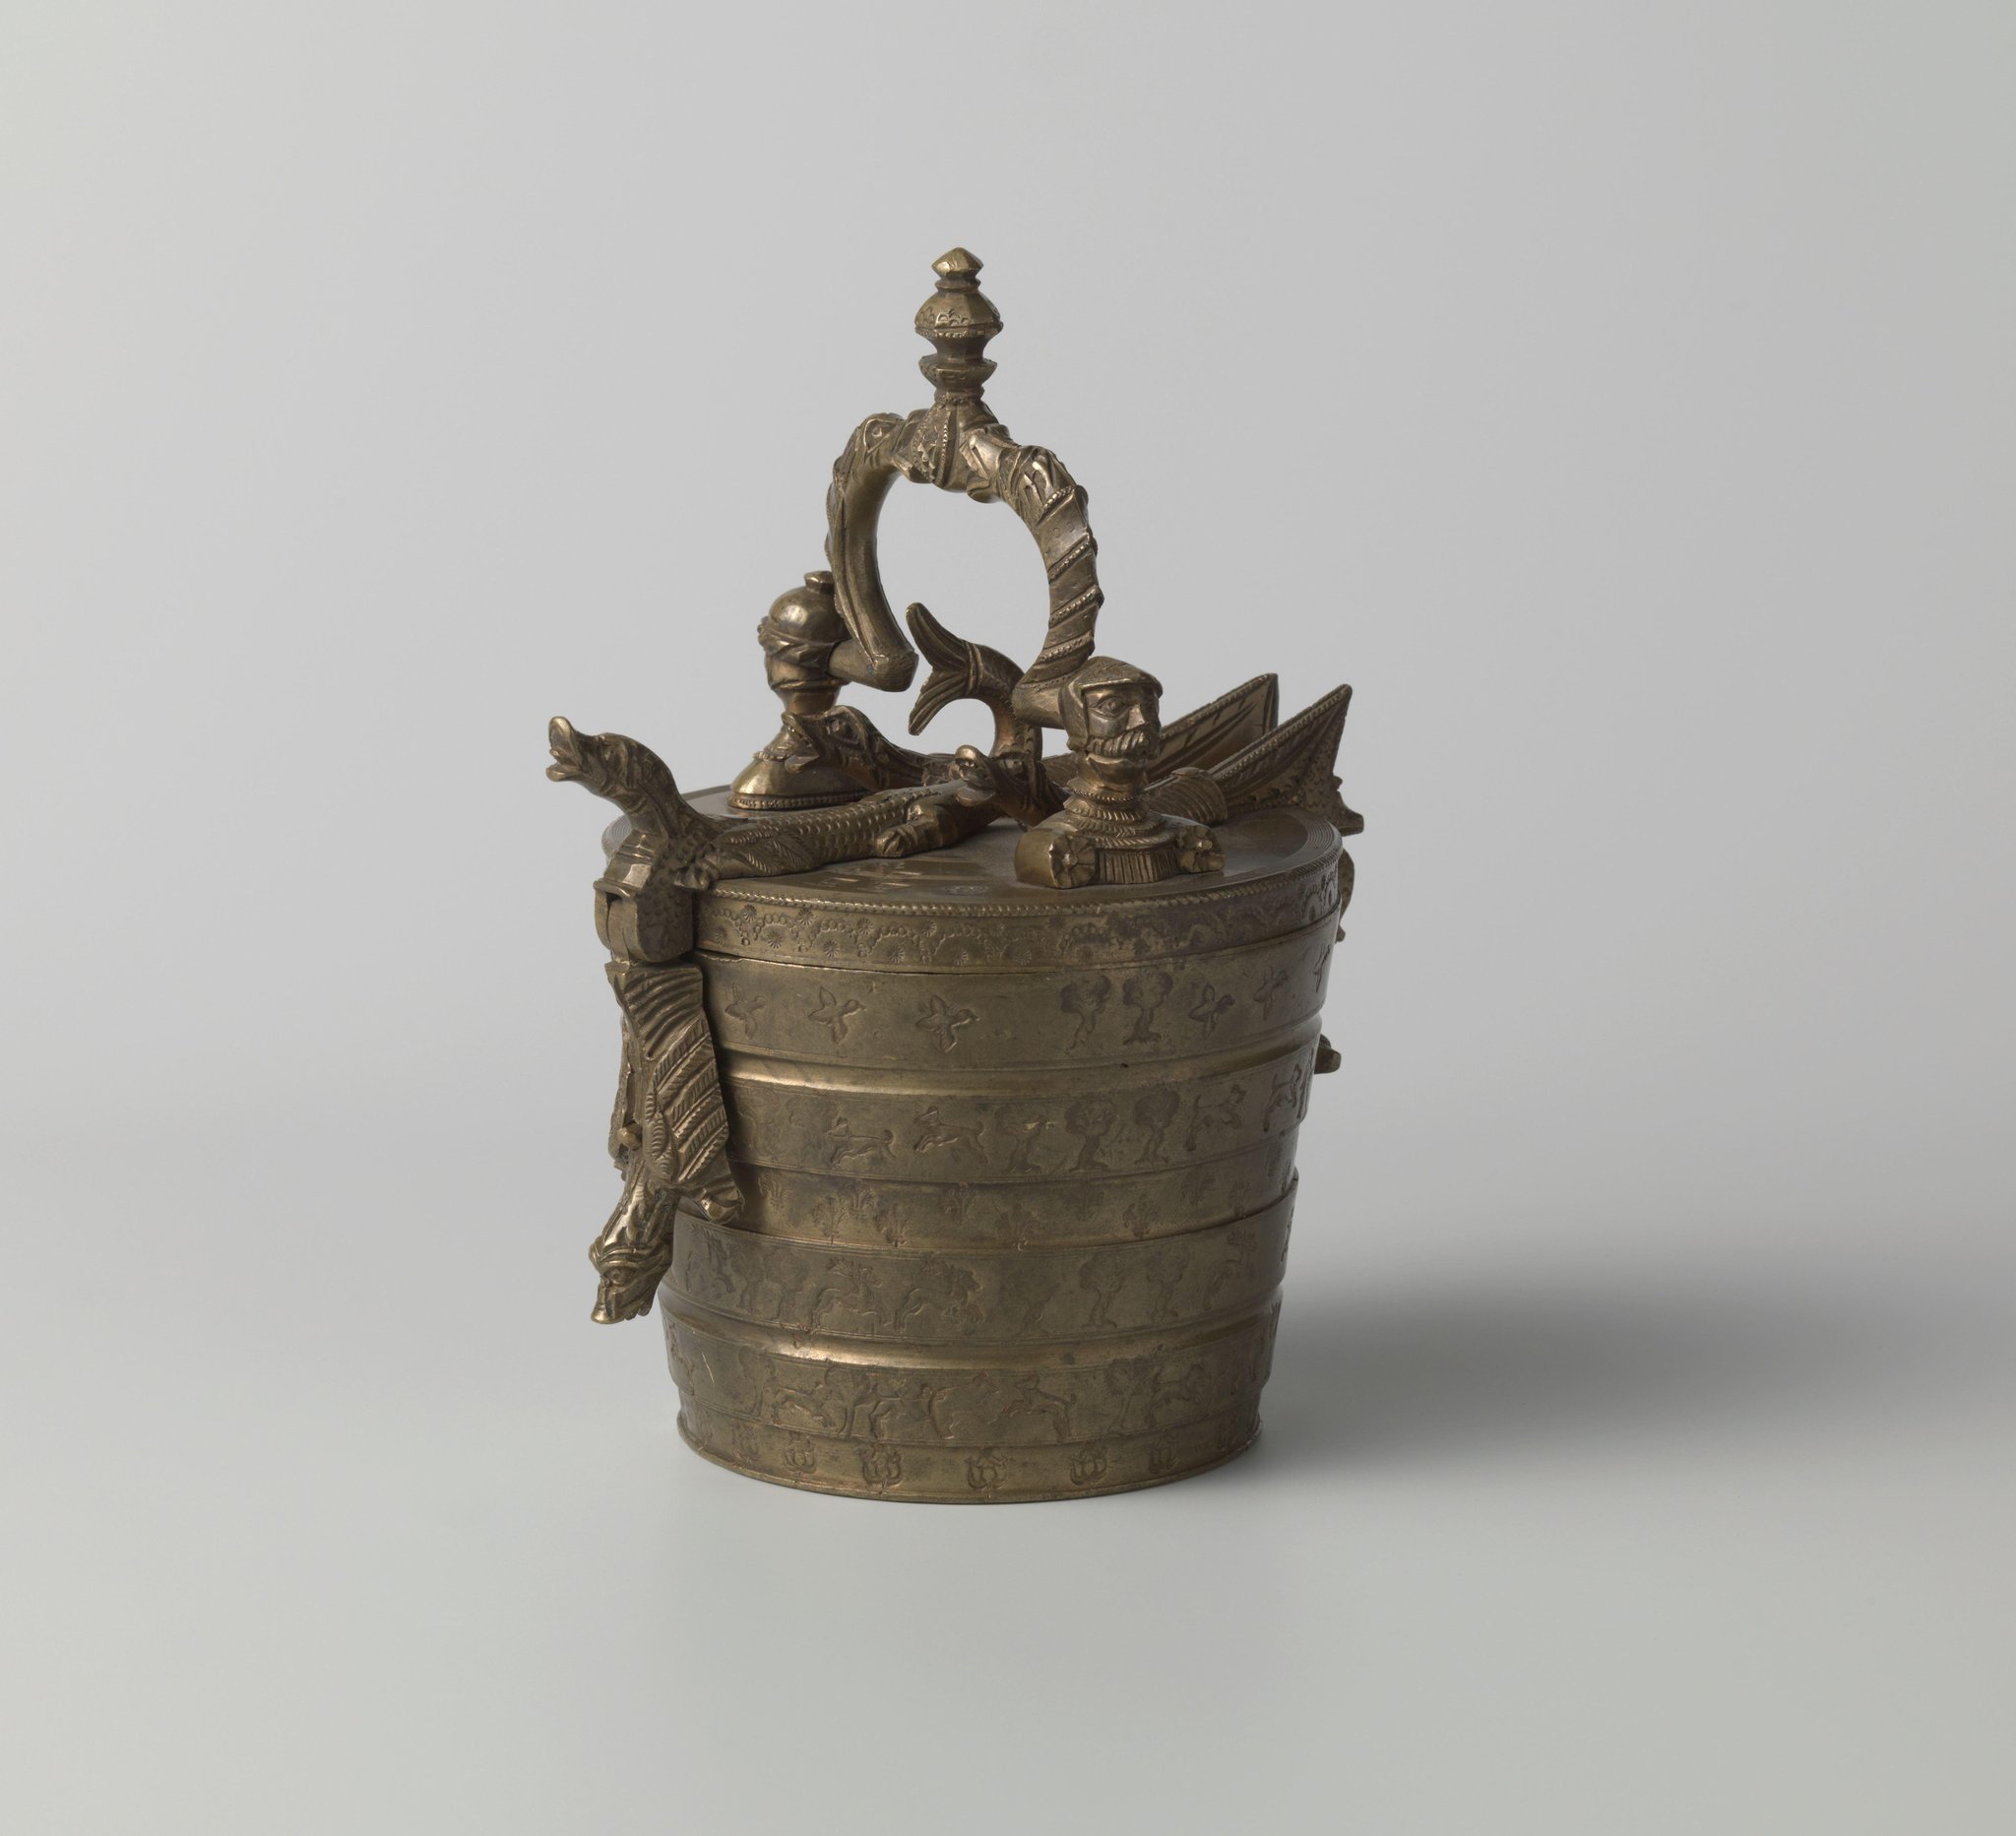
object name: weight scale component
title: Sluitgewicht van 16 pond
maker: Anonymous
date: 1571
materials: brass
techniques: casting, punching, riveted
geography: nuremberg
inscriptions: ijkmerk, aan weerszijden van het sluitscharnier, onderzijde bodem eerste gewicht en onderzijde bodem derde gewicht, afgeslagen: letter D met drie kronen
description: Nest of weights of 16 lb. Brass. Nüremberg, 1571.